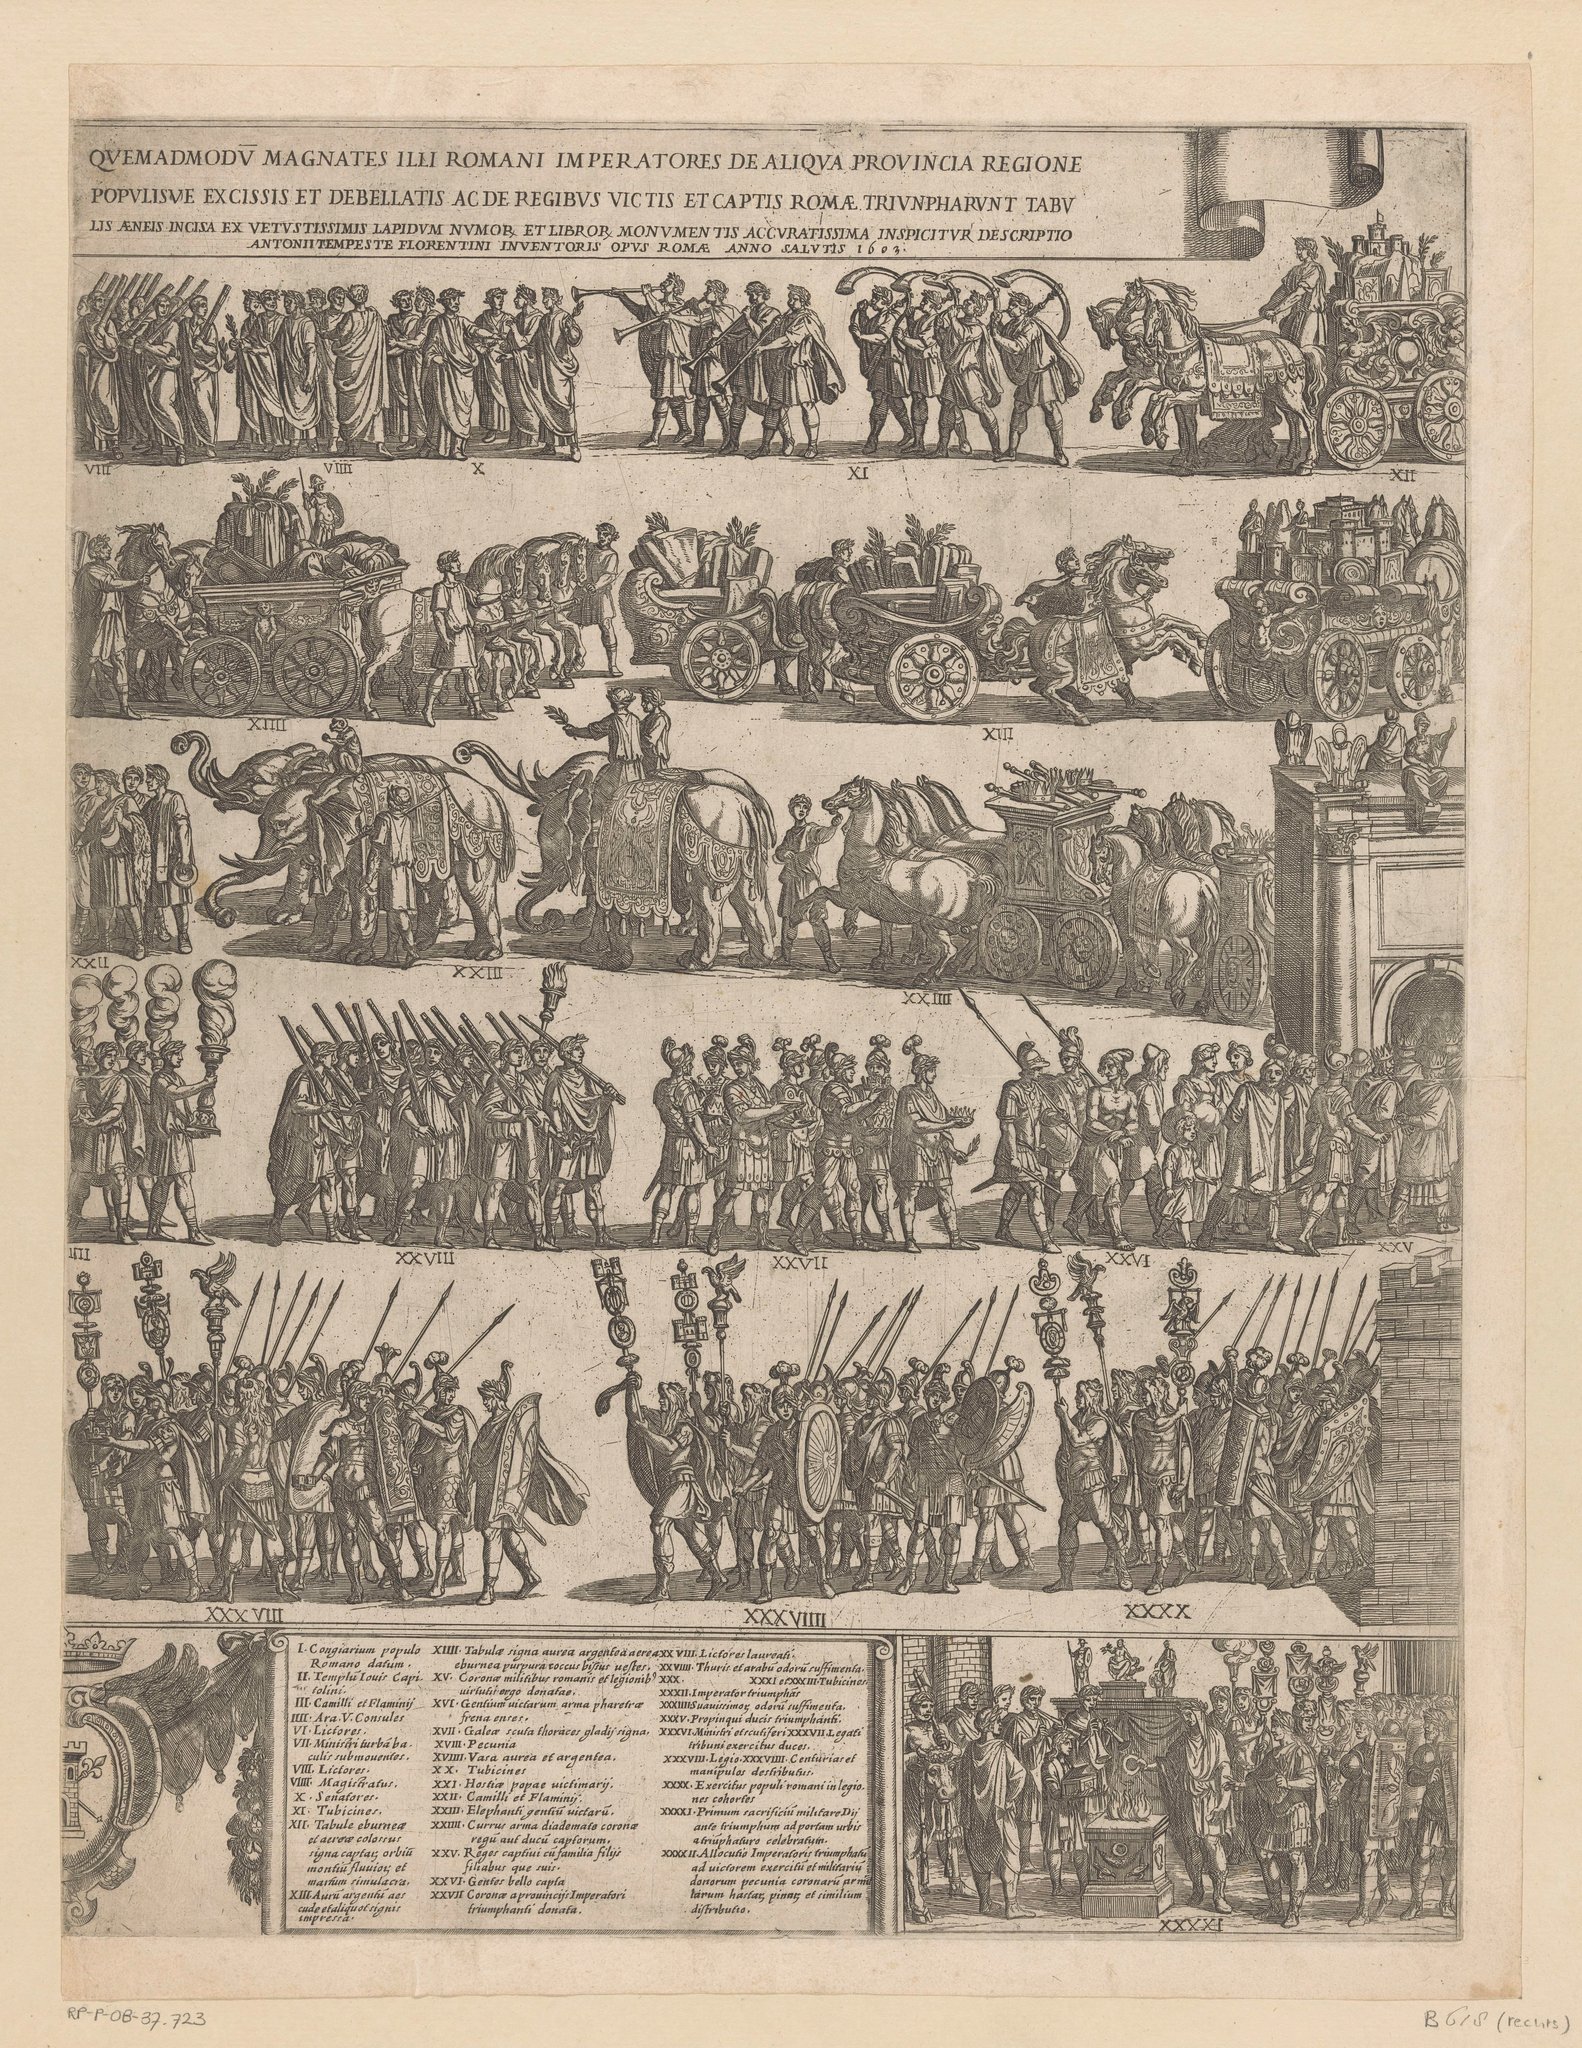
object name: print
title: Triomf van een Romeins keizer (rechter deel)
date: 1603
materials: paper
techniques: etching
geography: rome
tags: triumphal arch, triumphal entry and public reception, pageant, 'entrée solennelle', 'joyeuse entrée', emperor, carrying off the spoils of war, division of the spoils of war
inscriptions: collector's mark: Lugt 240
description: Een triomftocht van een Romeins keizer. De stoet trekt van rechtsonder, onder twee triomfbogen door, naar een tempel linksboven. De stoet bestaat uit soldaten, gevangenen, olifanten, wagens vol oorlogsbuit en de keizer. Linksonder een voorstelling van de keizer die de oorlogsbuit verdeelt. Rechtsonder een voorstelling van een offerscène en een verklarende lijst met nummers.